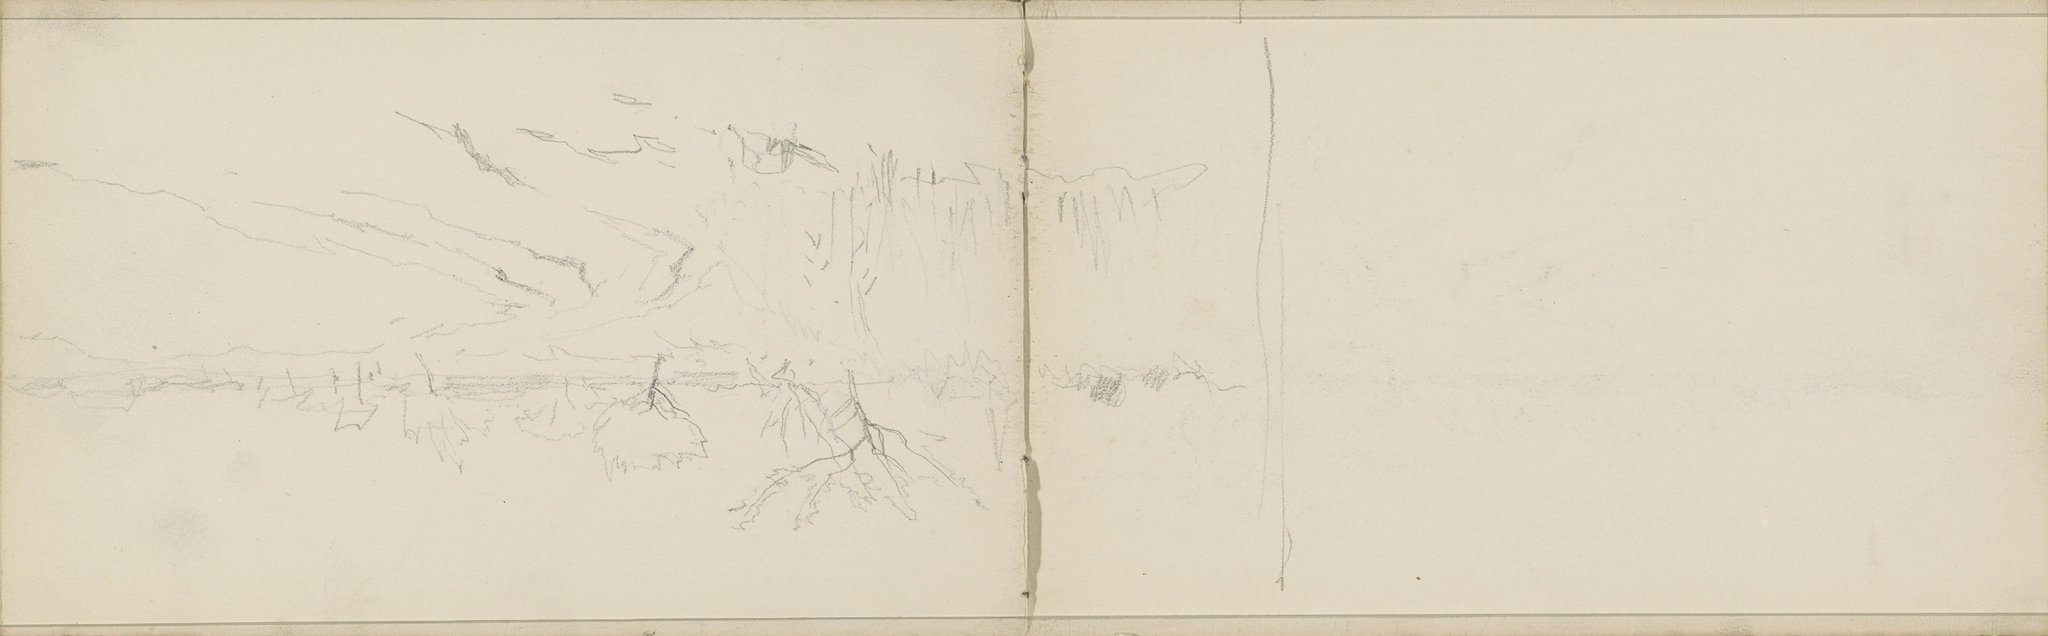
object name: sketchbook leaf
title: Landschap met bomen en een weg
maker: anton mauve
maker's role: draughtsman, painter, print maker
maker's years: 1838-1888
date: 1848-1888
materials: paper, pencil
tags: landscapes, road, path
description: Blad 38 verso en 39 recto uit een schetsboek met 42 bladen.